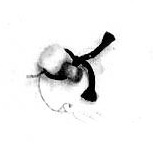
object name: bead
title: Beads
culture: japanese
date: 601-700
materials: glass, lacquer